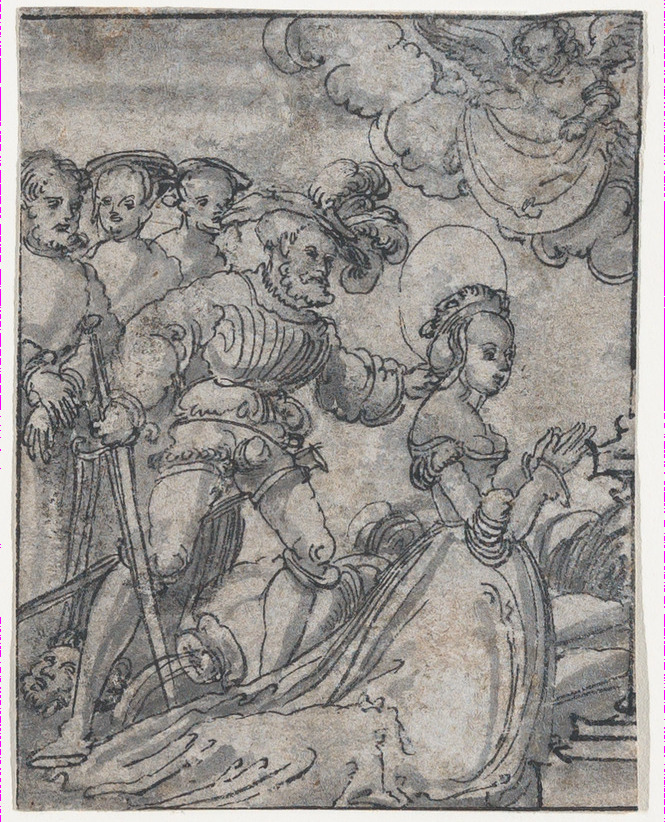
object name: drawing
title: The Martyrdom of Saint Catherine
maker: anonymous, german, 16th century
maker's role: artist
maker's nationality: german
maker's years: 1500-1600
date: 1501-1533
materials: ink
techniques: pen, wash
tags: men,angels,saint catherine